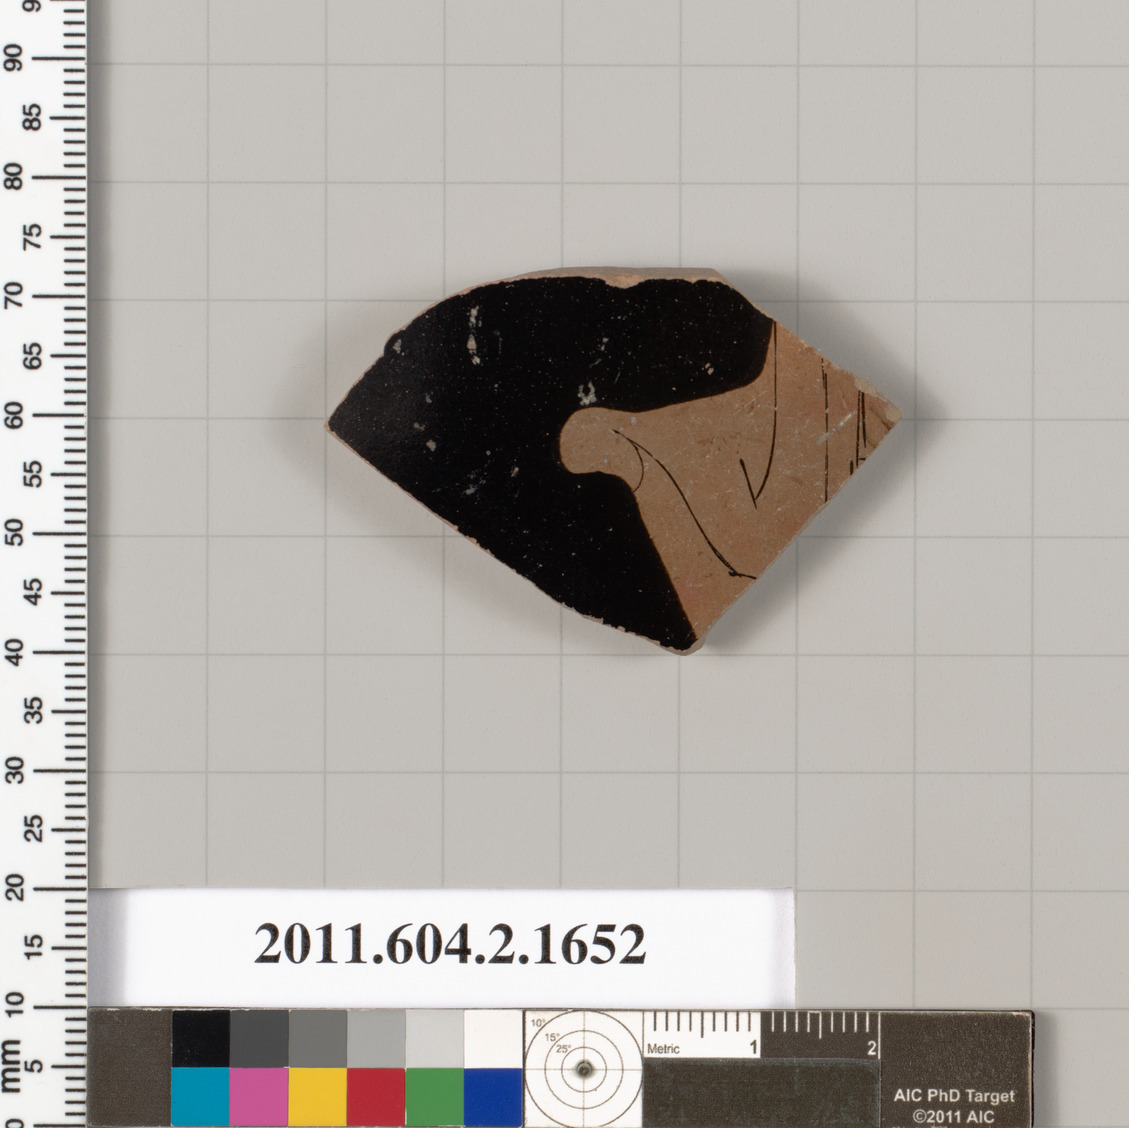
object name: skyphos fragment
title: Terracotta fragment of a skyphos (deep drinking cup)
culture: greek, attic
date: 450-426 BCE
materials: terracotta